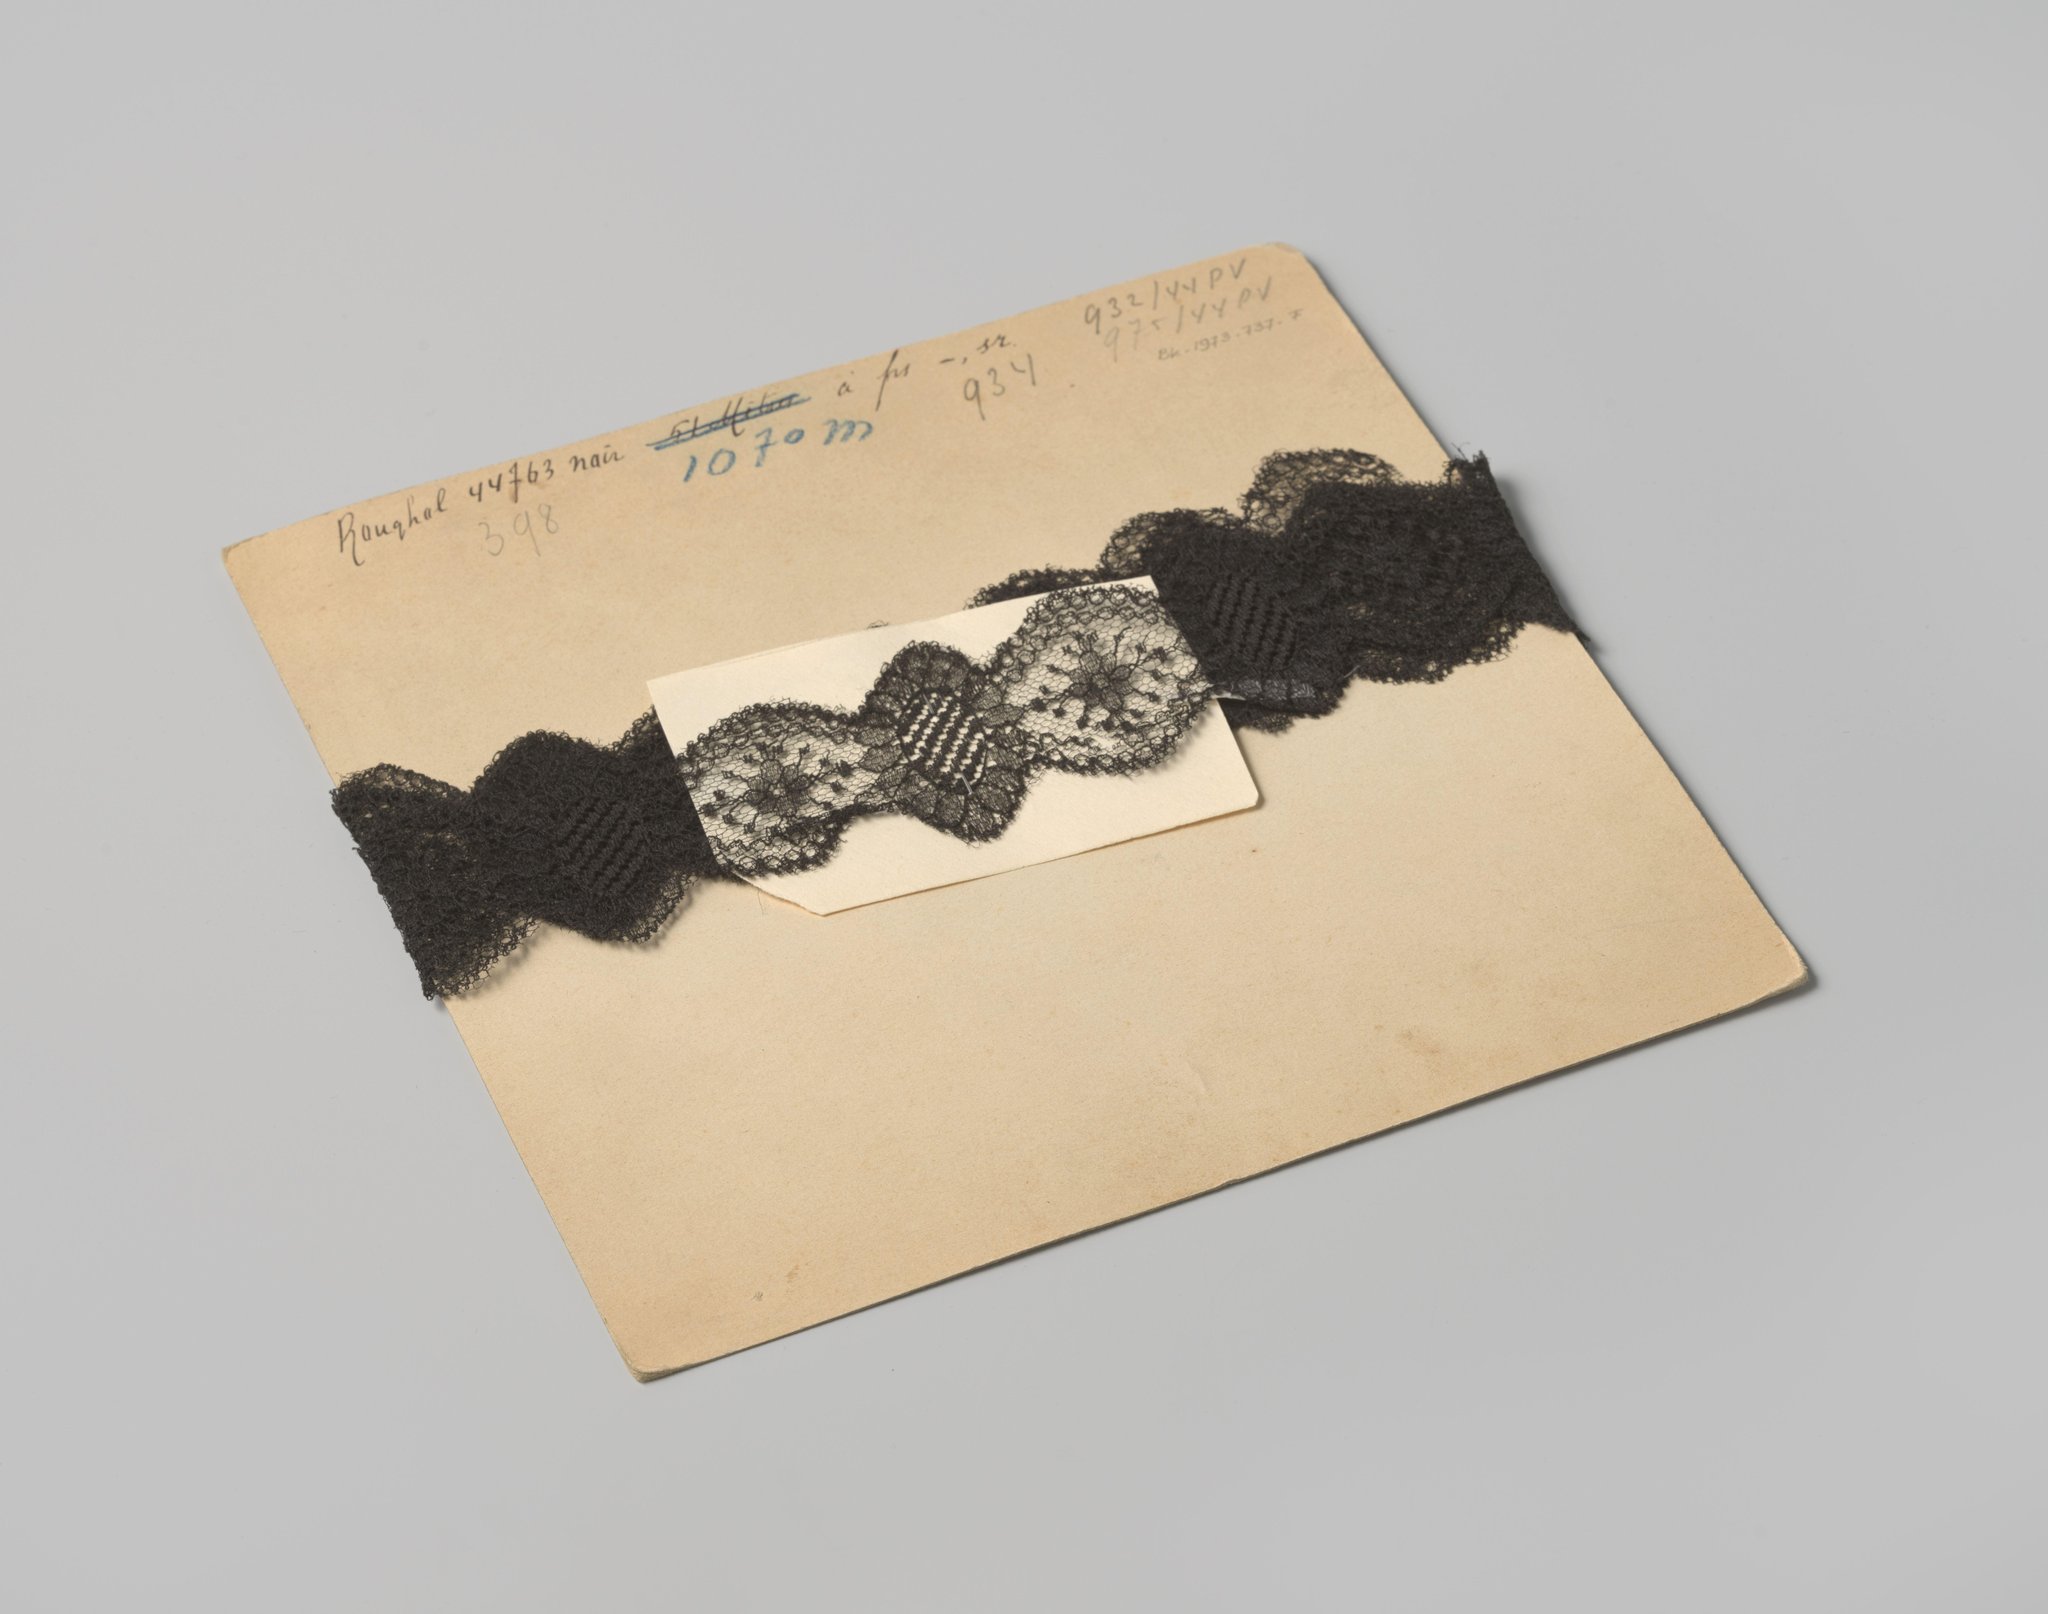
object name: braid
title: Strook dubbelzijdig geschulpte zwarte machinale kant, op karton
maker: gustav schnitzler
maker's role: paraplufabrikant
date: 1925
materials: cardboard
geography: nijmegen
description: Metrages kant en passement, in wit en zwart en andere kleuren. karton met zwarte eenzijdig geschulpte kant.